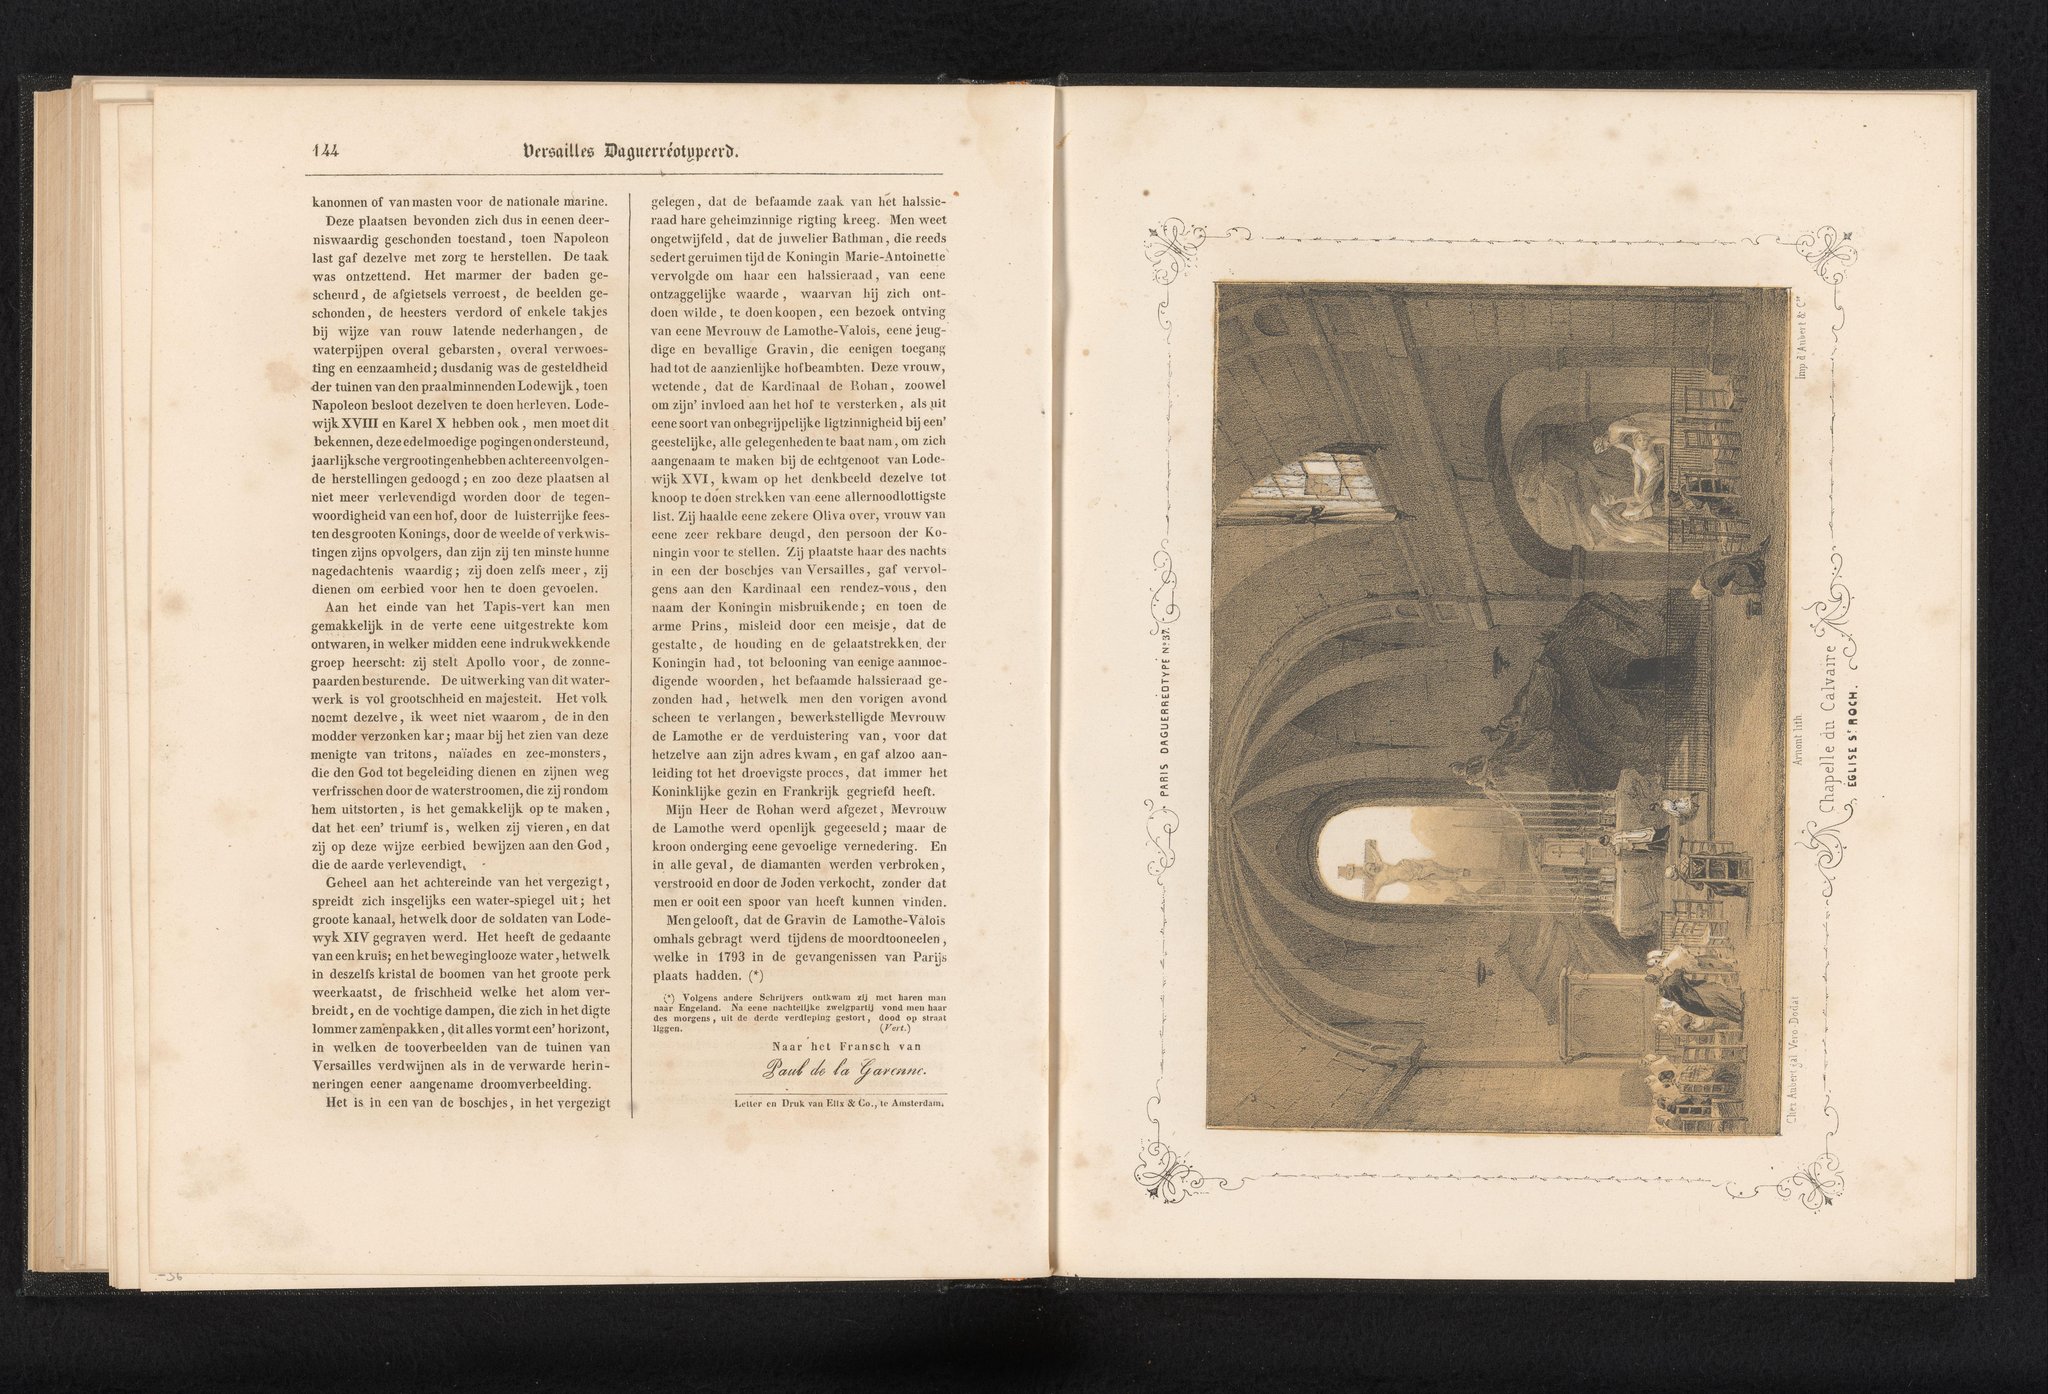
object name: print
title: Chapelle du Calvaire in de Église Saint-Roch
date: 1839-1840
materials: paper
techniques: tone lithography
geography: paris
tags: parts of church interior: chapel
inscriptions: inscription: ‘PARIS DAGUERRÉOTYPÉ No. 37.’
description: Prent op honderdzevenenveertigste ongenummerde pagina.